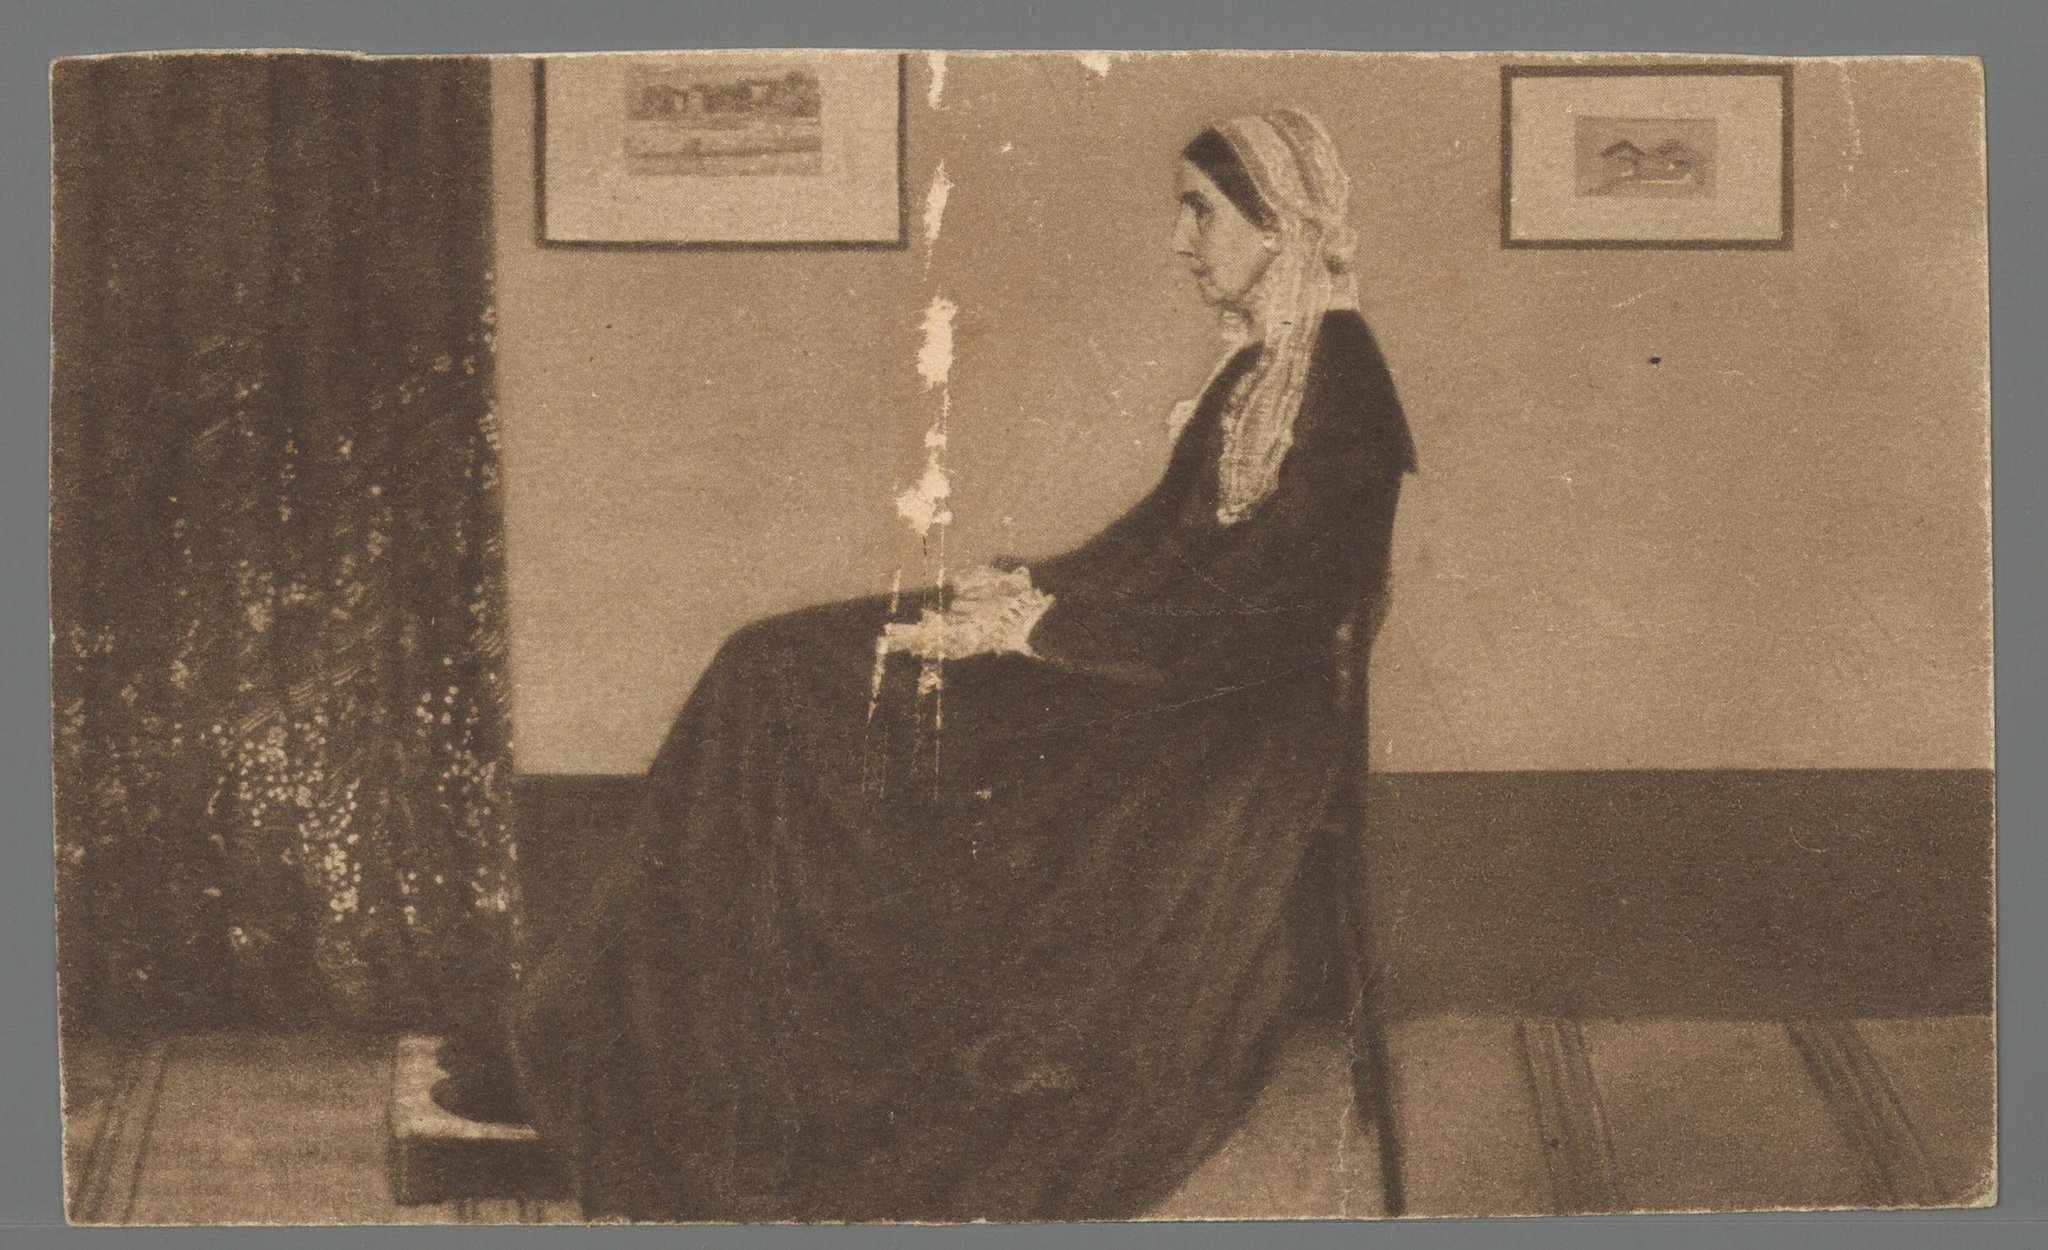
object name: photomechanical print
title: Whistler's moeder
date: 1905-1916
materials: cardboard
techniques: rotogravure, writing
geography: utrecht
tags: sitting figure - aa - female human figure, historical persons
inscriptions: collector's mark: ‘AFE v S’, postage stamp